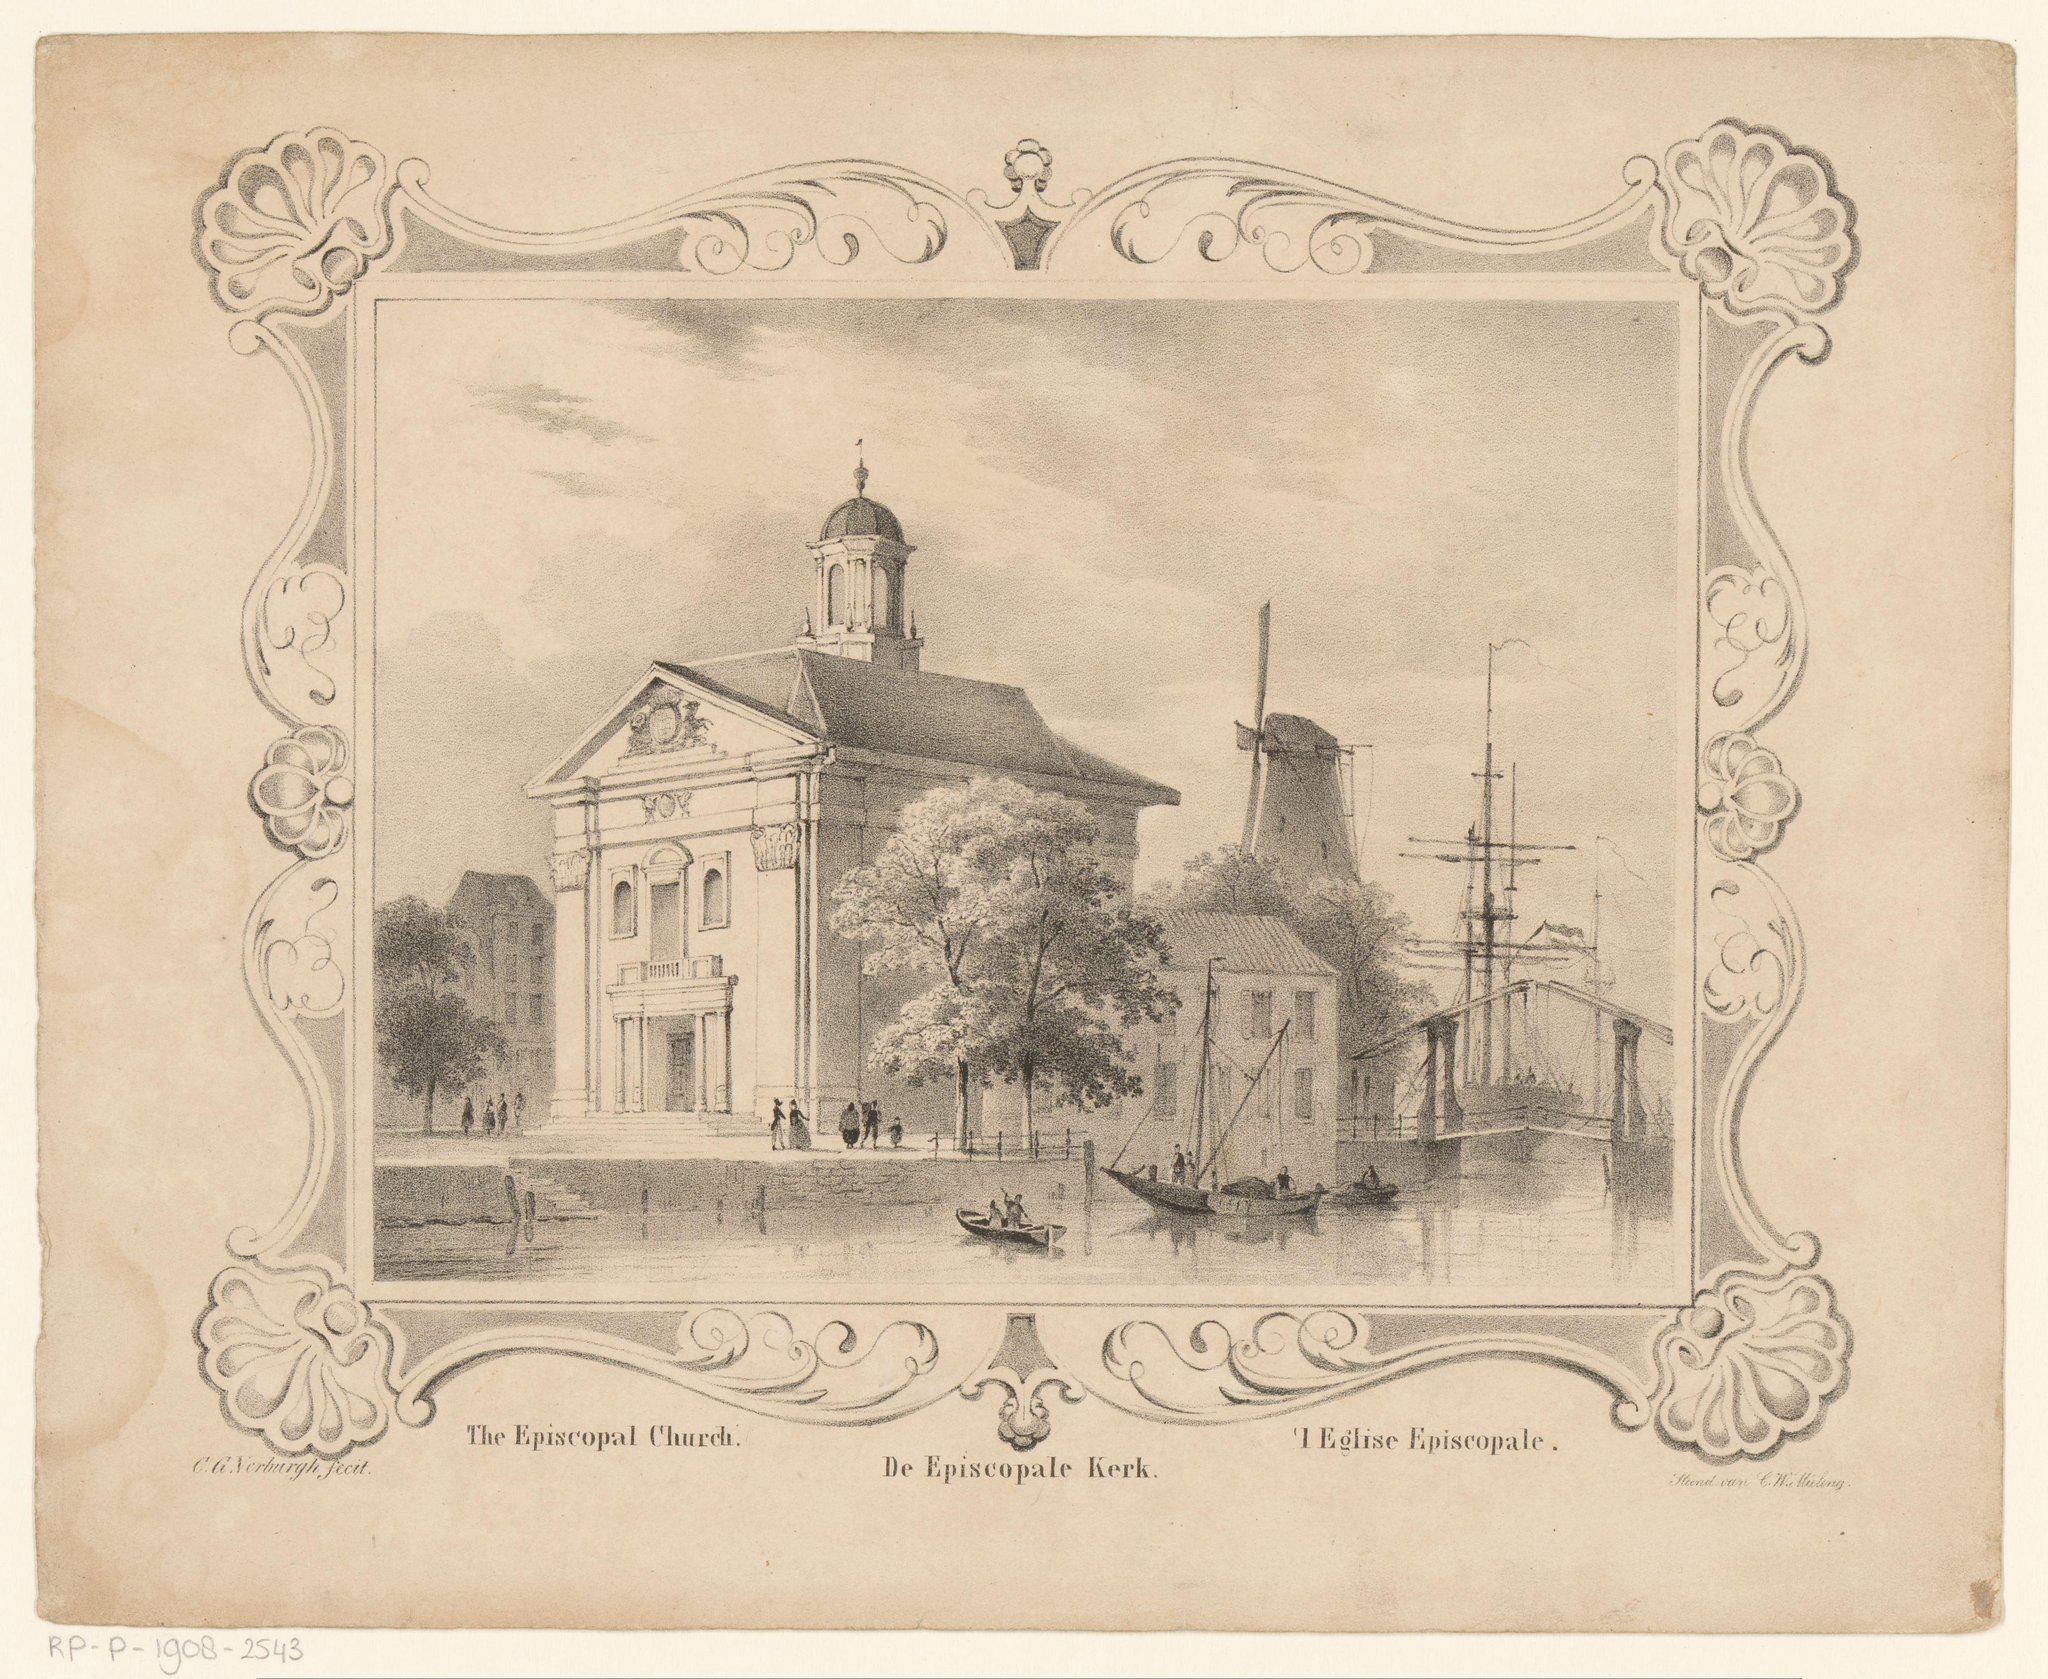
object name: print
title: Gezicht op St. Mary's Church te Rotterdam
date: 1839-1846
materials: paper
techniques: lithograph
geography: rotterdam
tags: church (exterior), rotterdam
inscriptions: collector's mark: Lugt 2228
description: Gezicht op de St. Mary's Church, gevat in een ornamentele omlijsting.